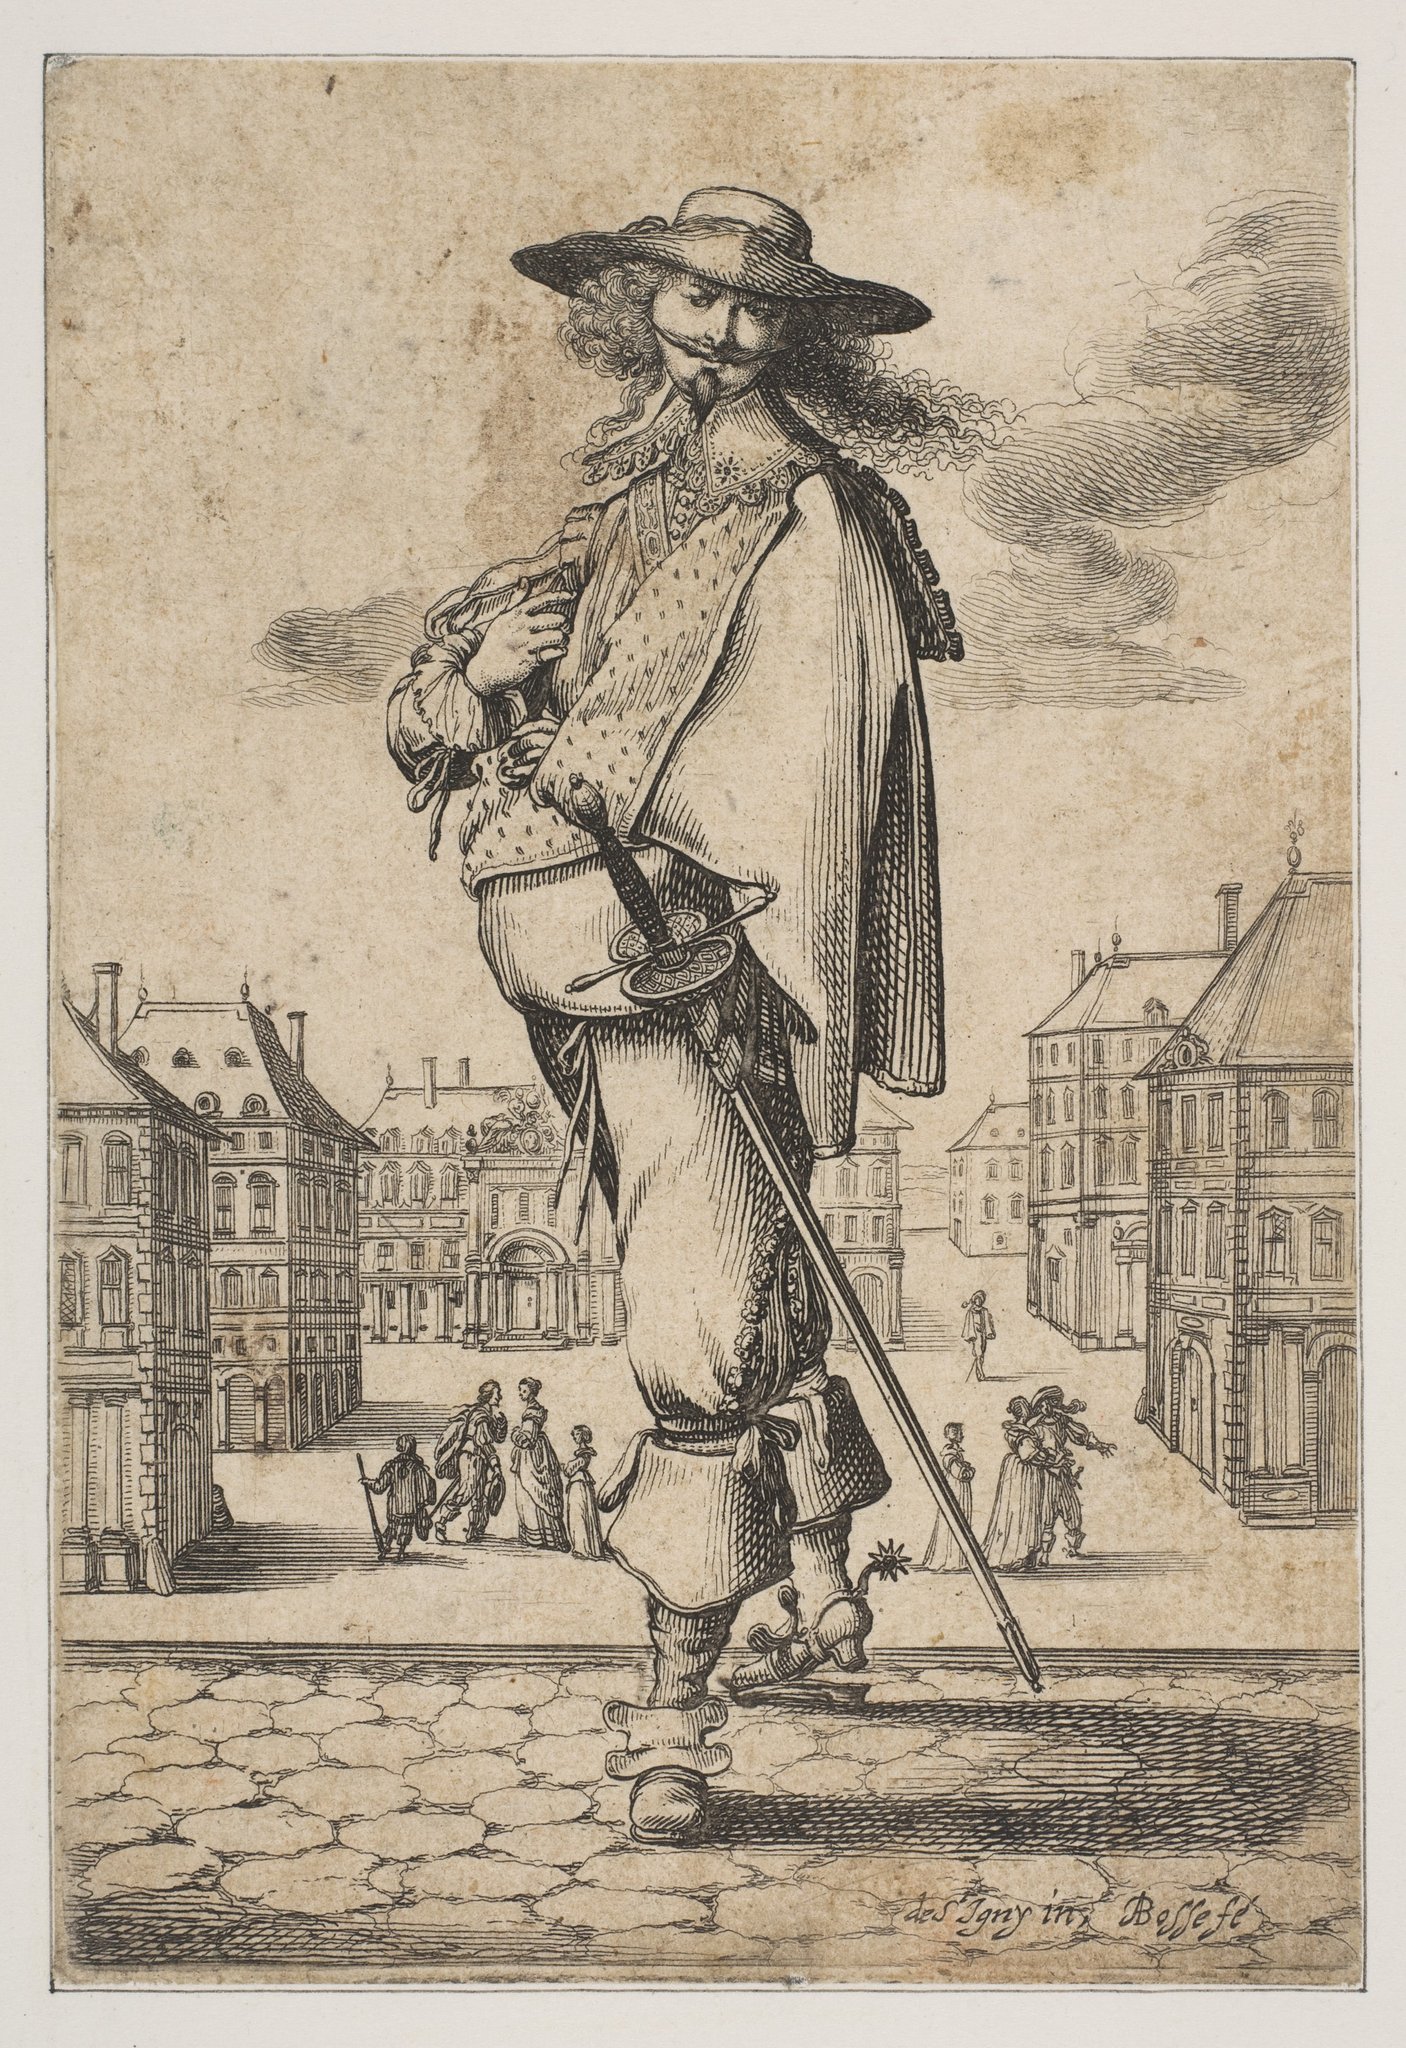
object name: print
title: Gentleman with a Sword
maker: abraham bosse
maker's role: artist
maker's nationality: french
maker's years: 1602-1676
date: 1629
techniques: etching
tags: buildings,swords,men